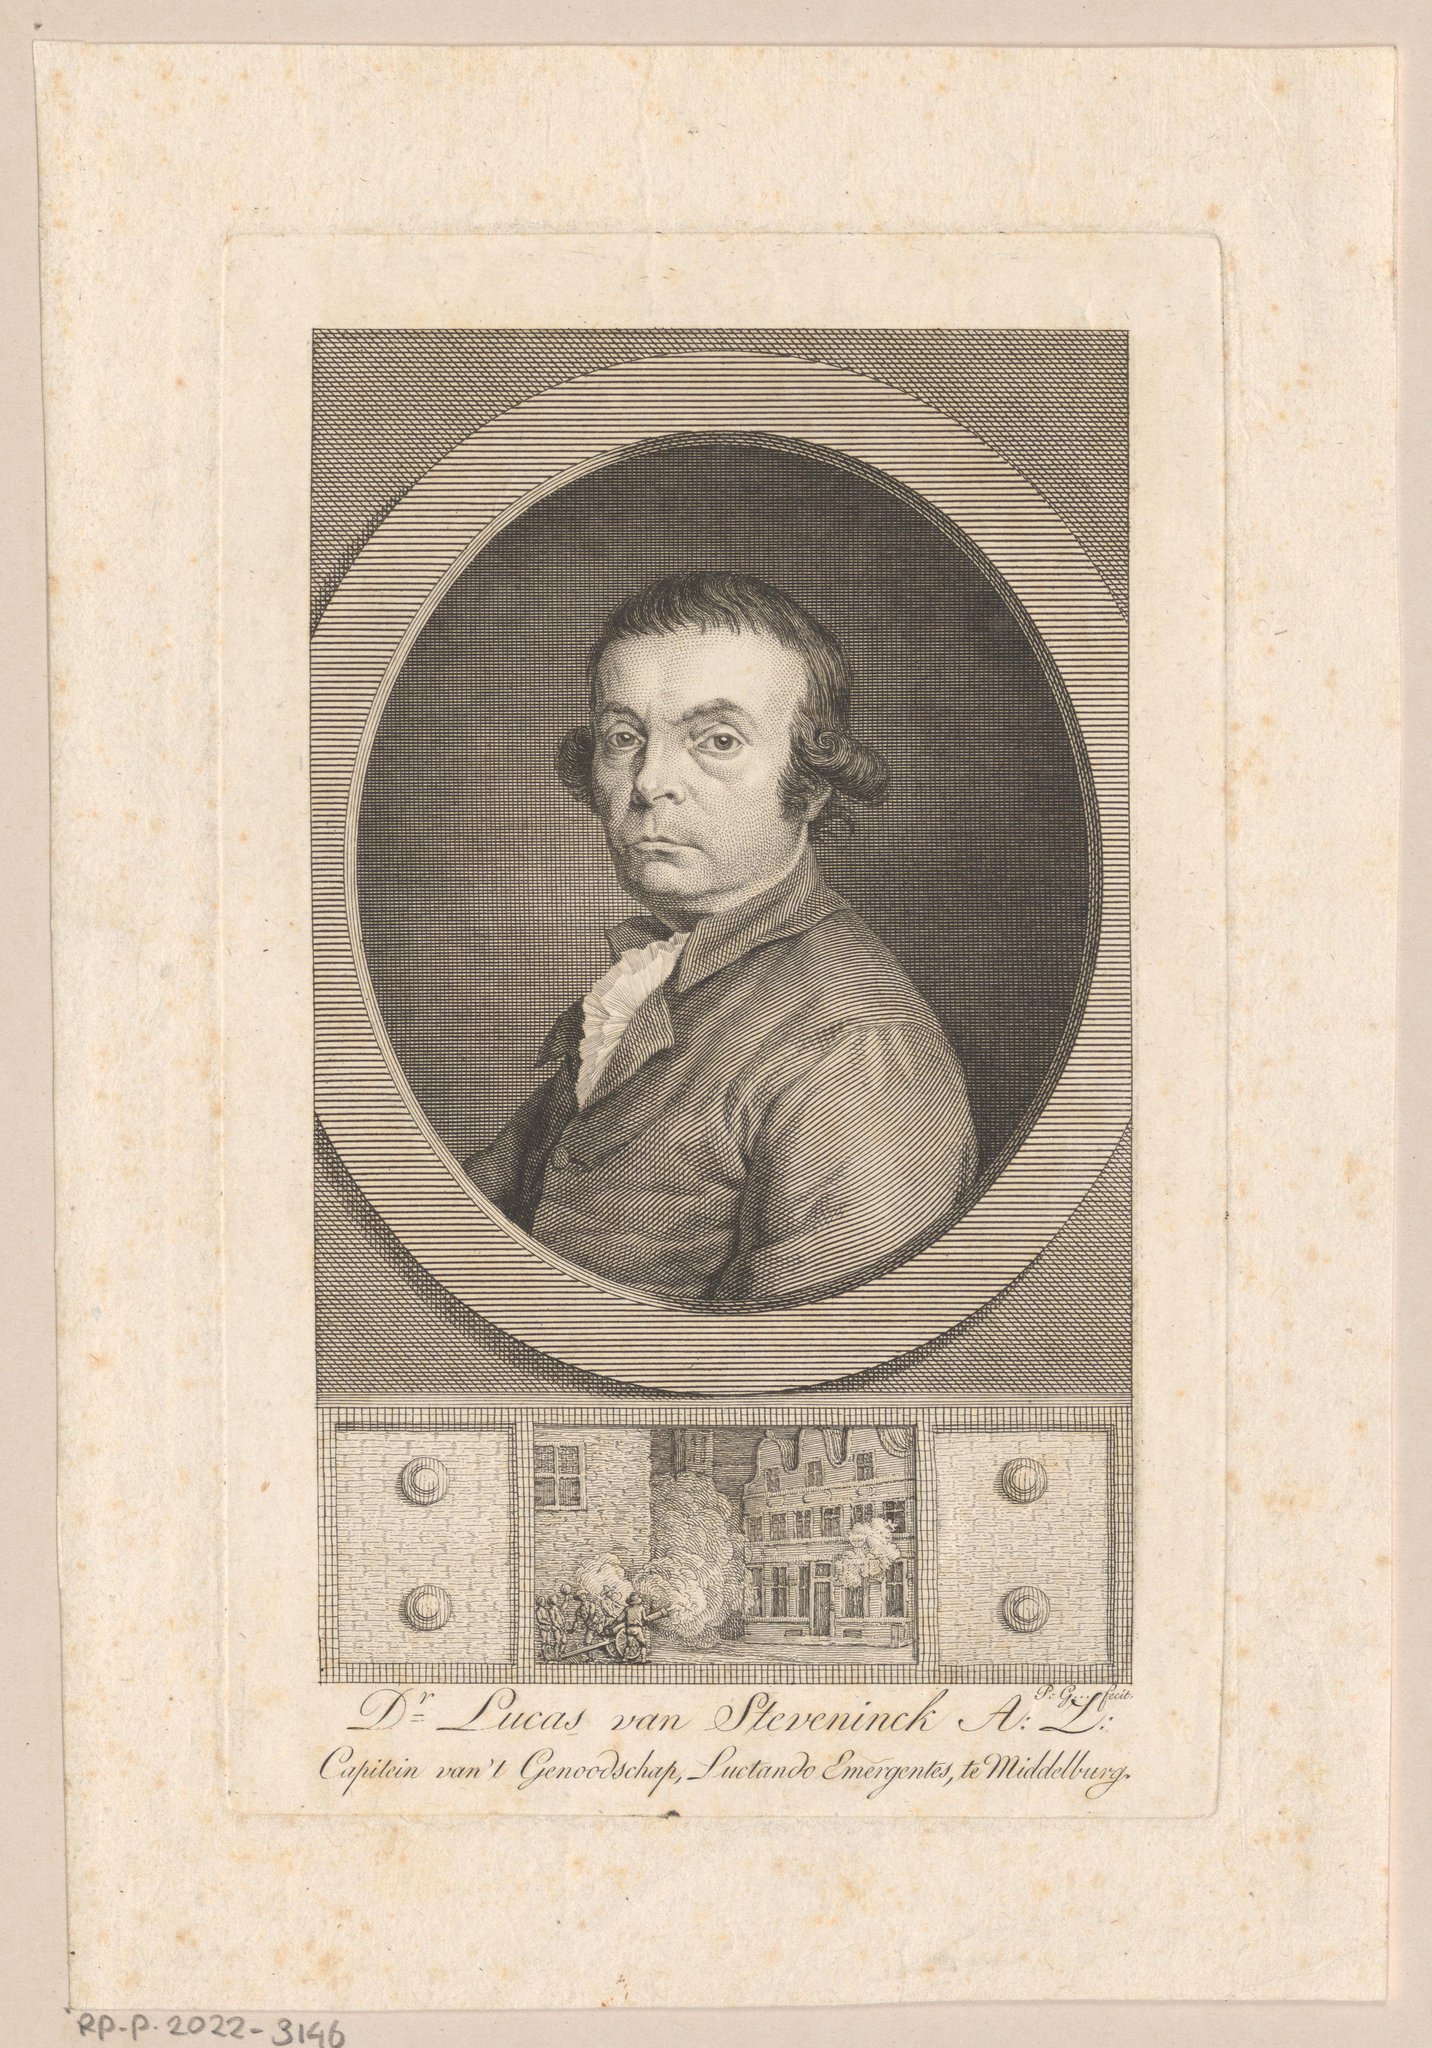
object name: print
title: Portret van Lucas van Steveninck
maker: pieter gaal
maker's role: draughtsman, print maker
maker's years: 1769-1819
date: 1787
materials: paper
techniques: engraving, etching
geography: netherlands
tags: amsterdam, historical persons, physician, doctor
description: Met tweeregelig onderschrift in het Nederlands.